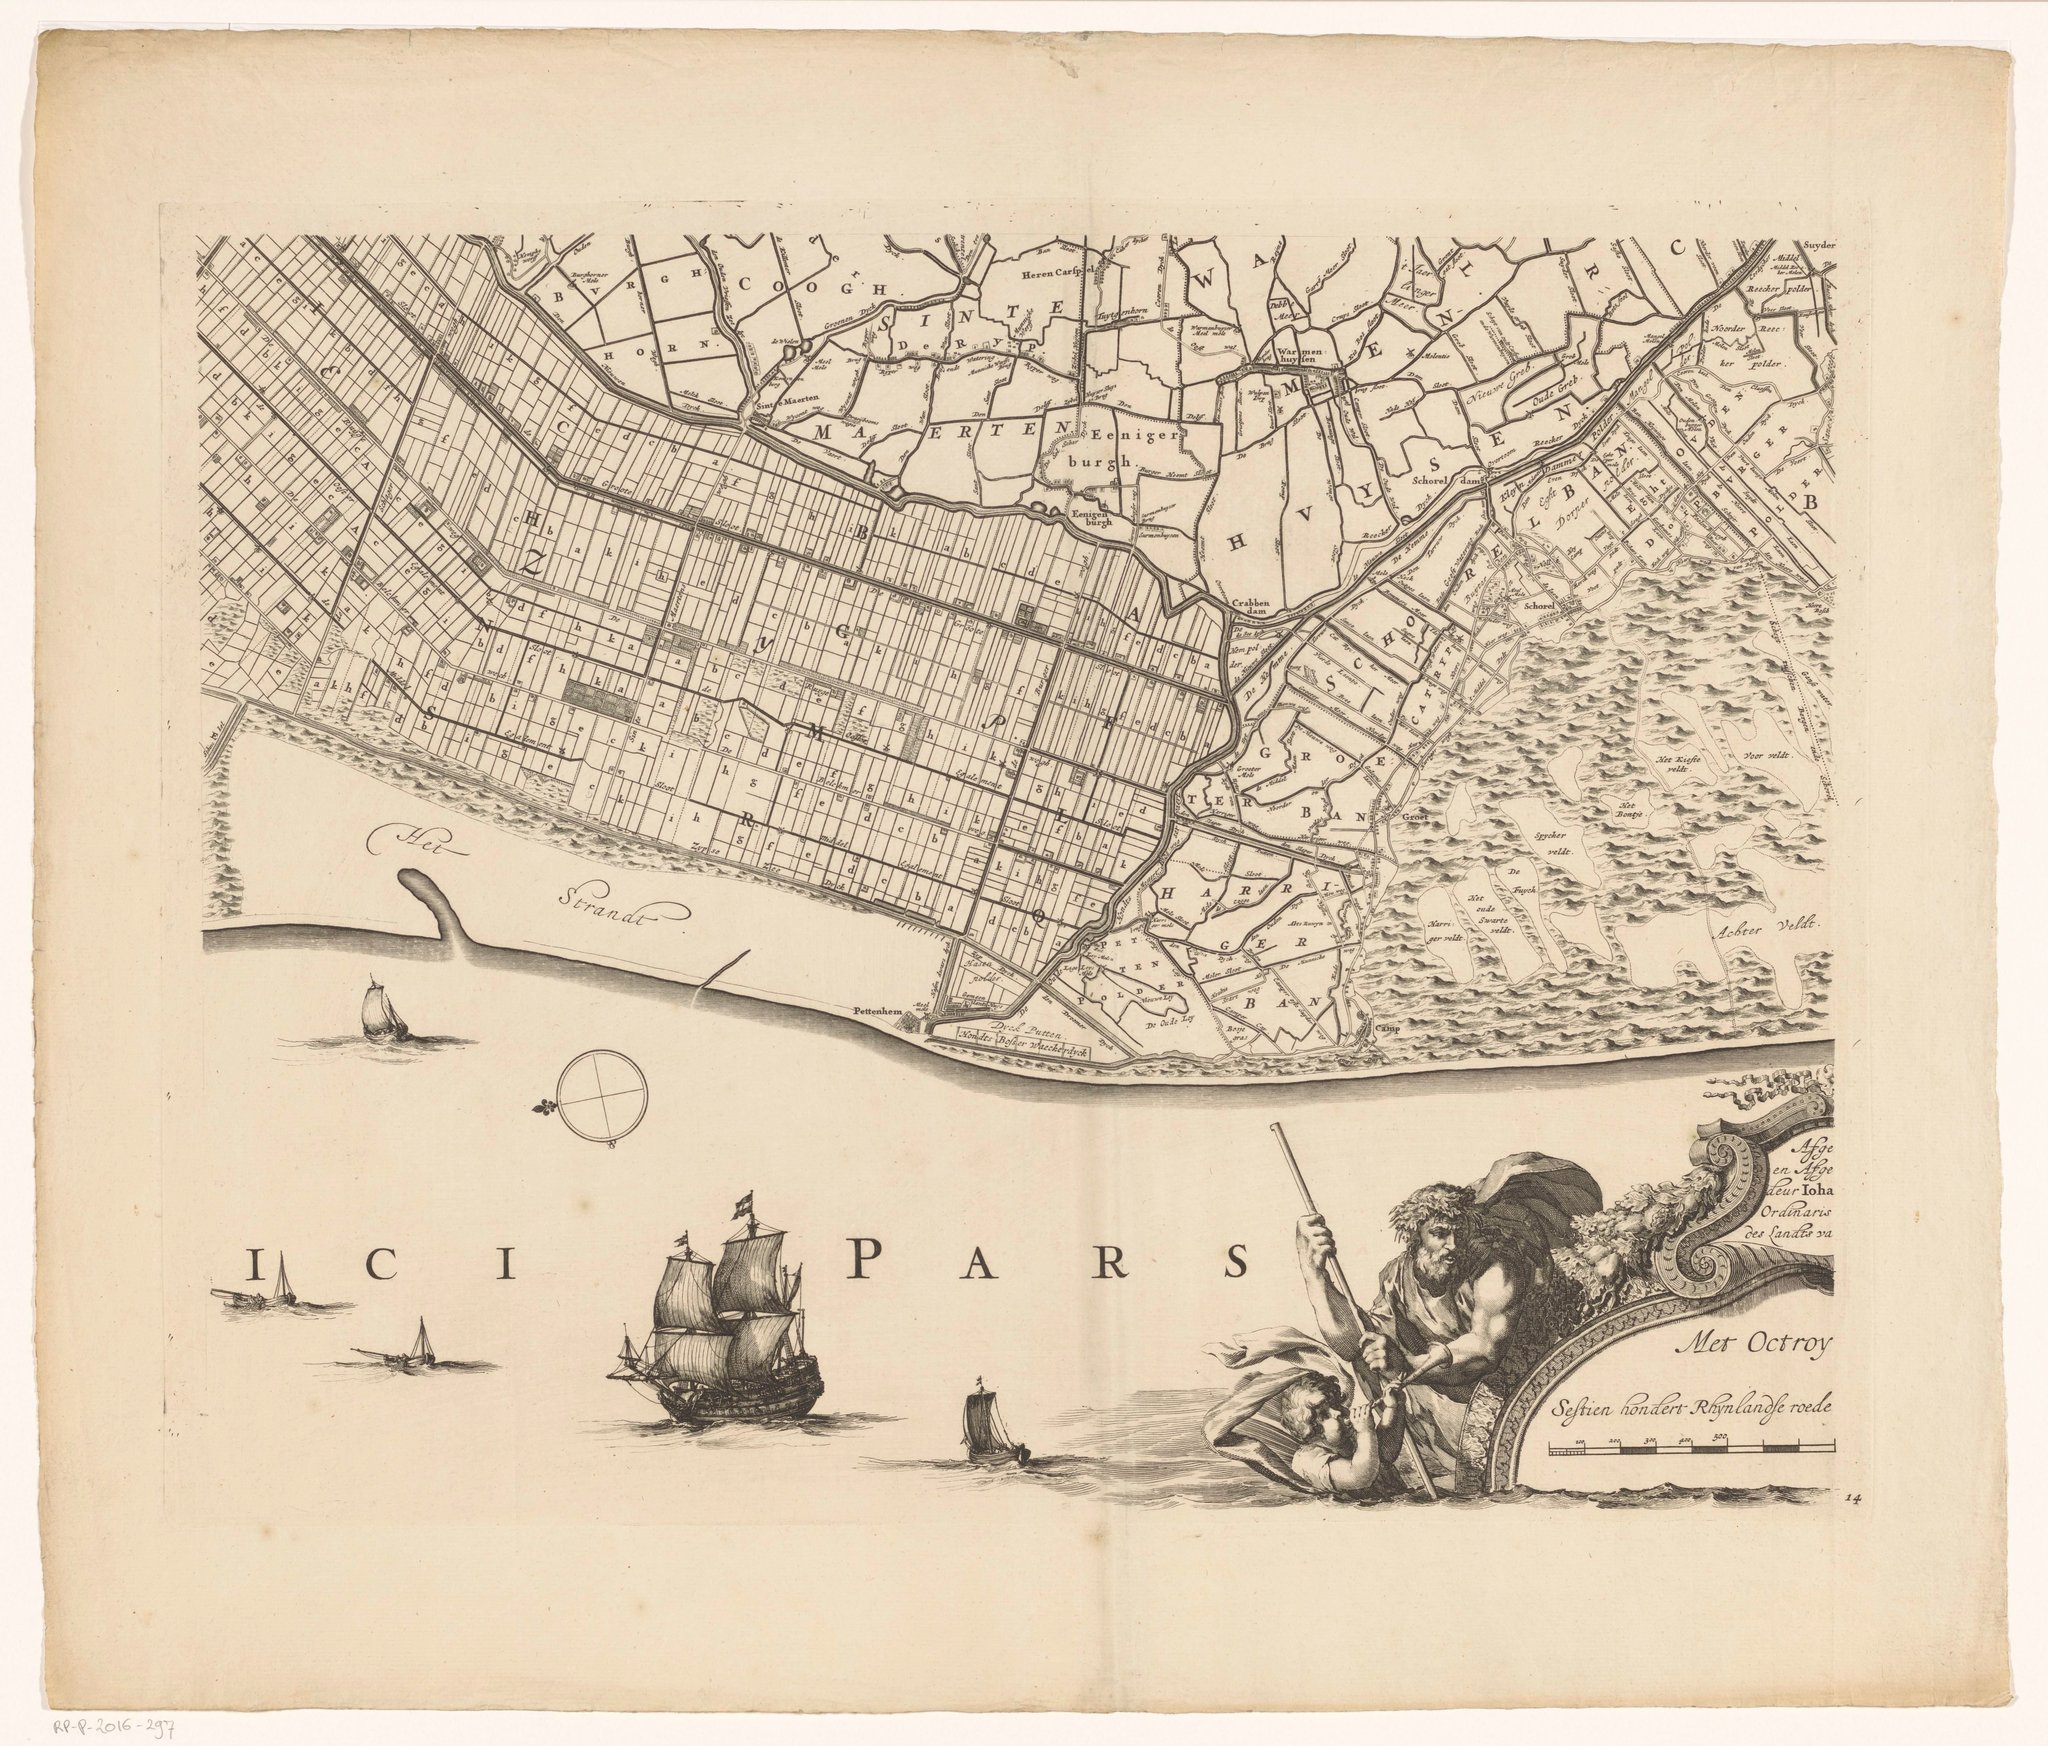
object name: map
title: Kaart van Kennemerland en West-Friesland (veertiende deel)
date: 1680-1811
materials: paper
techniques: engraving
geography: amsterdam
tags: maps of separate countries or regions, river-gods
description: Deze prent is oorspronkelijk onderdeel van een zestiendelige wandkaart van Kennemerland en West-Friesland, gemaakt door landmeter Jan Jansz Dou in opdracht van het Hoogheemraadschap van de Uitwaterende Sluizen in Kennemerland en West-Friesland. Voor een volledige versie van deze kaart zie: RP-P-AO-6-26. Voor een ander exemplaar van dit blad zie: RP-P-AO-6-26-14. Van deze kaart zijn drie staten bekend waarvan de eerste verscheen in 1680 bij uitgever Jan Karels te Amsterdam, de tweede in 1729 bij Andries en Hendrik de Leth te Amsterdam en de derde in 1745 bij Isaak Tirion te Amsterdam. De derde staat werd in 1811 nogmaals gedrukt bij A. Koning te Amsterdam. De verschillende staten van de kaart zijn te dateren aan de hand van de namen van de dijkgraaf, hoogheemraden en rentmeester die te vinden zijn op de bovenste bladen van de kaart. Aangezien het huidige exemplaar een los blad is van de onderste rij bladen van de kaart kan het niet precies gedateerd worden. Vlak na het verschijnen van de wandkaart werd besloten tevens een vierblads (RP-P-AO-6-25A, RP-P-AO-6-25B, RP-P-AO-6-25C en RP-P-AO-6-25D) en een éénblads uitgave (RP-P-AO-6-24-1 en RP-P-AO-6-24-2) te laten maken. Alle drie de kaarten werden gegraveerd door Coenraet Decker en Abraham Jansz. Deur, die verantwoordelijk was voor het graveren van de letters.